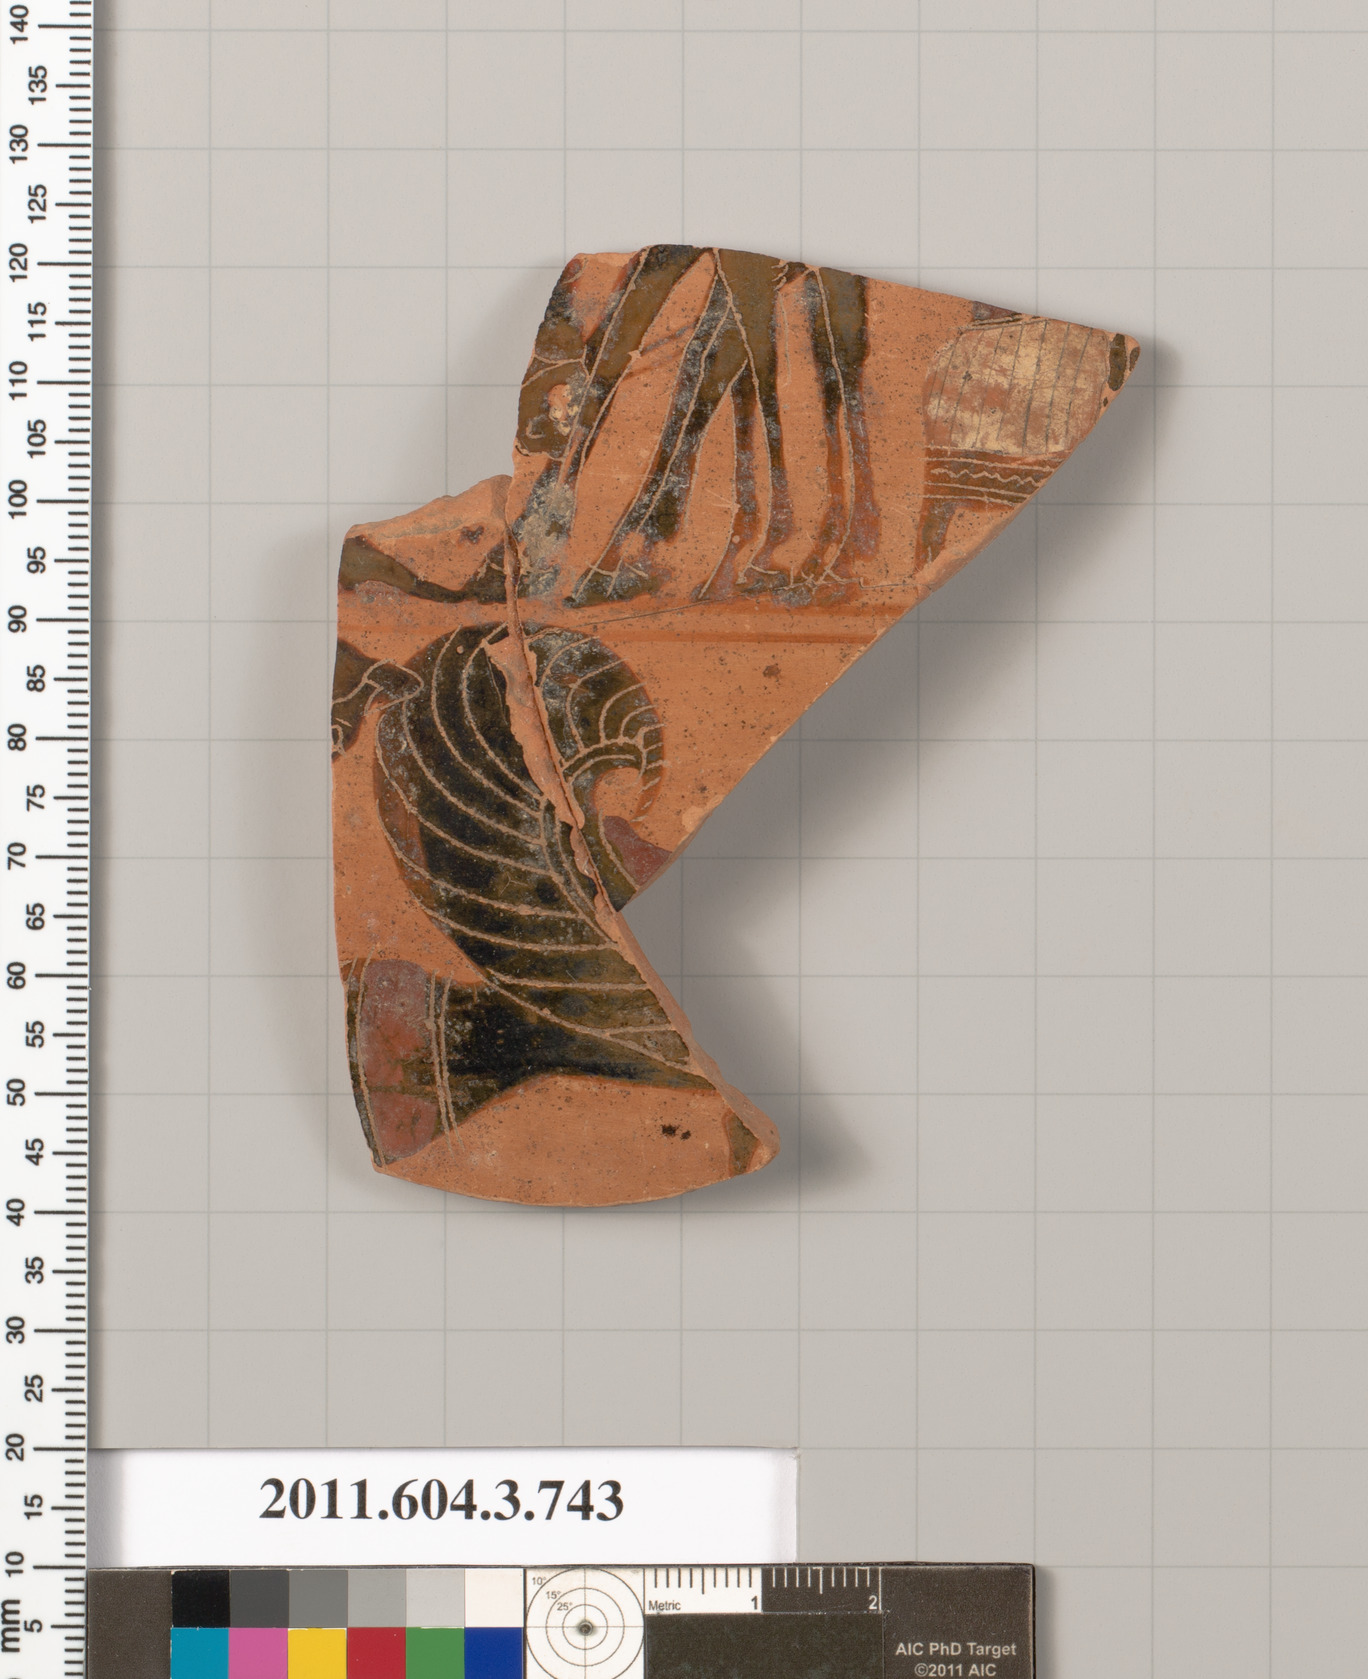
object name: neck amphora, tyrrhenian fragment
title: Terracotta fragment of a neck-amphora (jar)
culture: greek, attic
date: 575-551 BCE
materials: terracotta